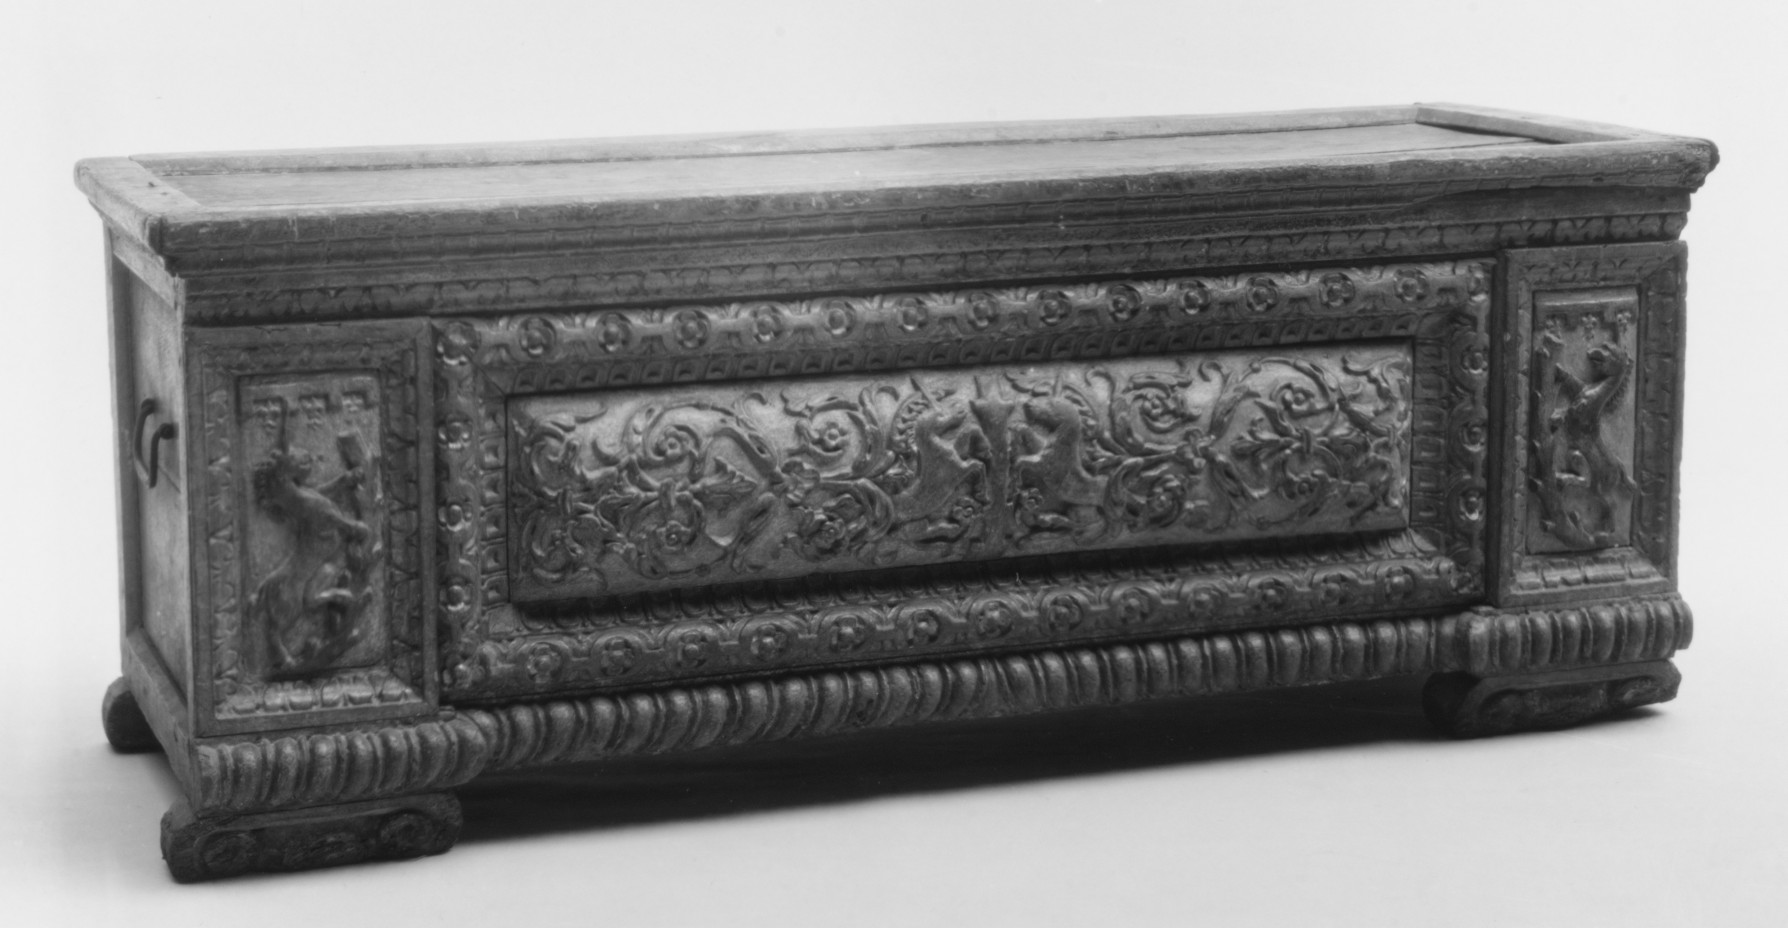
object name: cassone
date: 1501-1550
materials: wood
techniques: gilding, polychrome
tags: unicorns